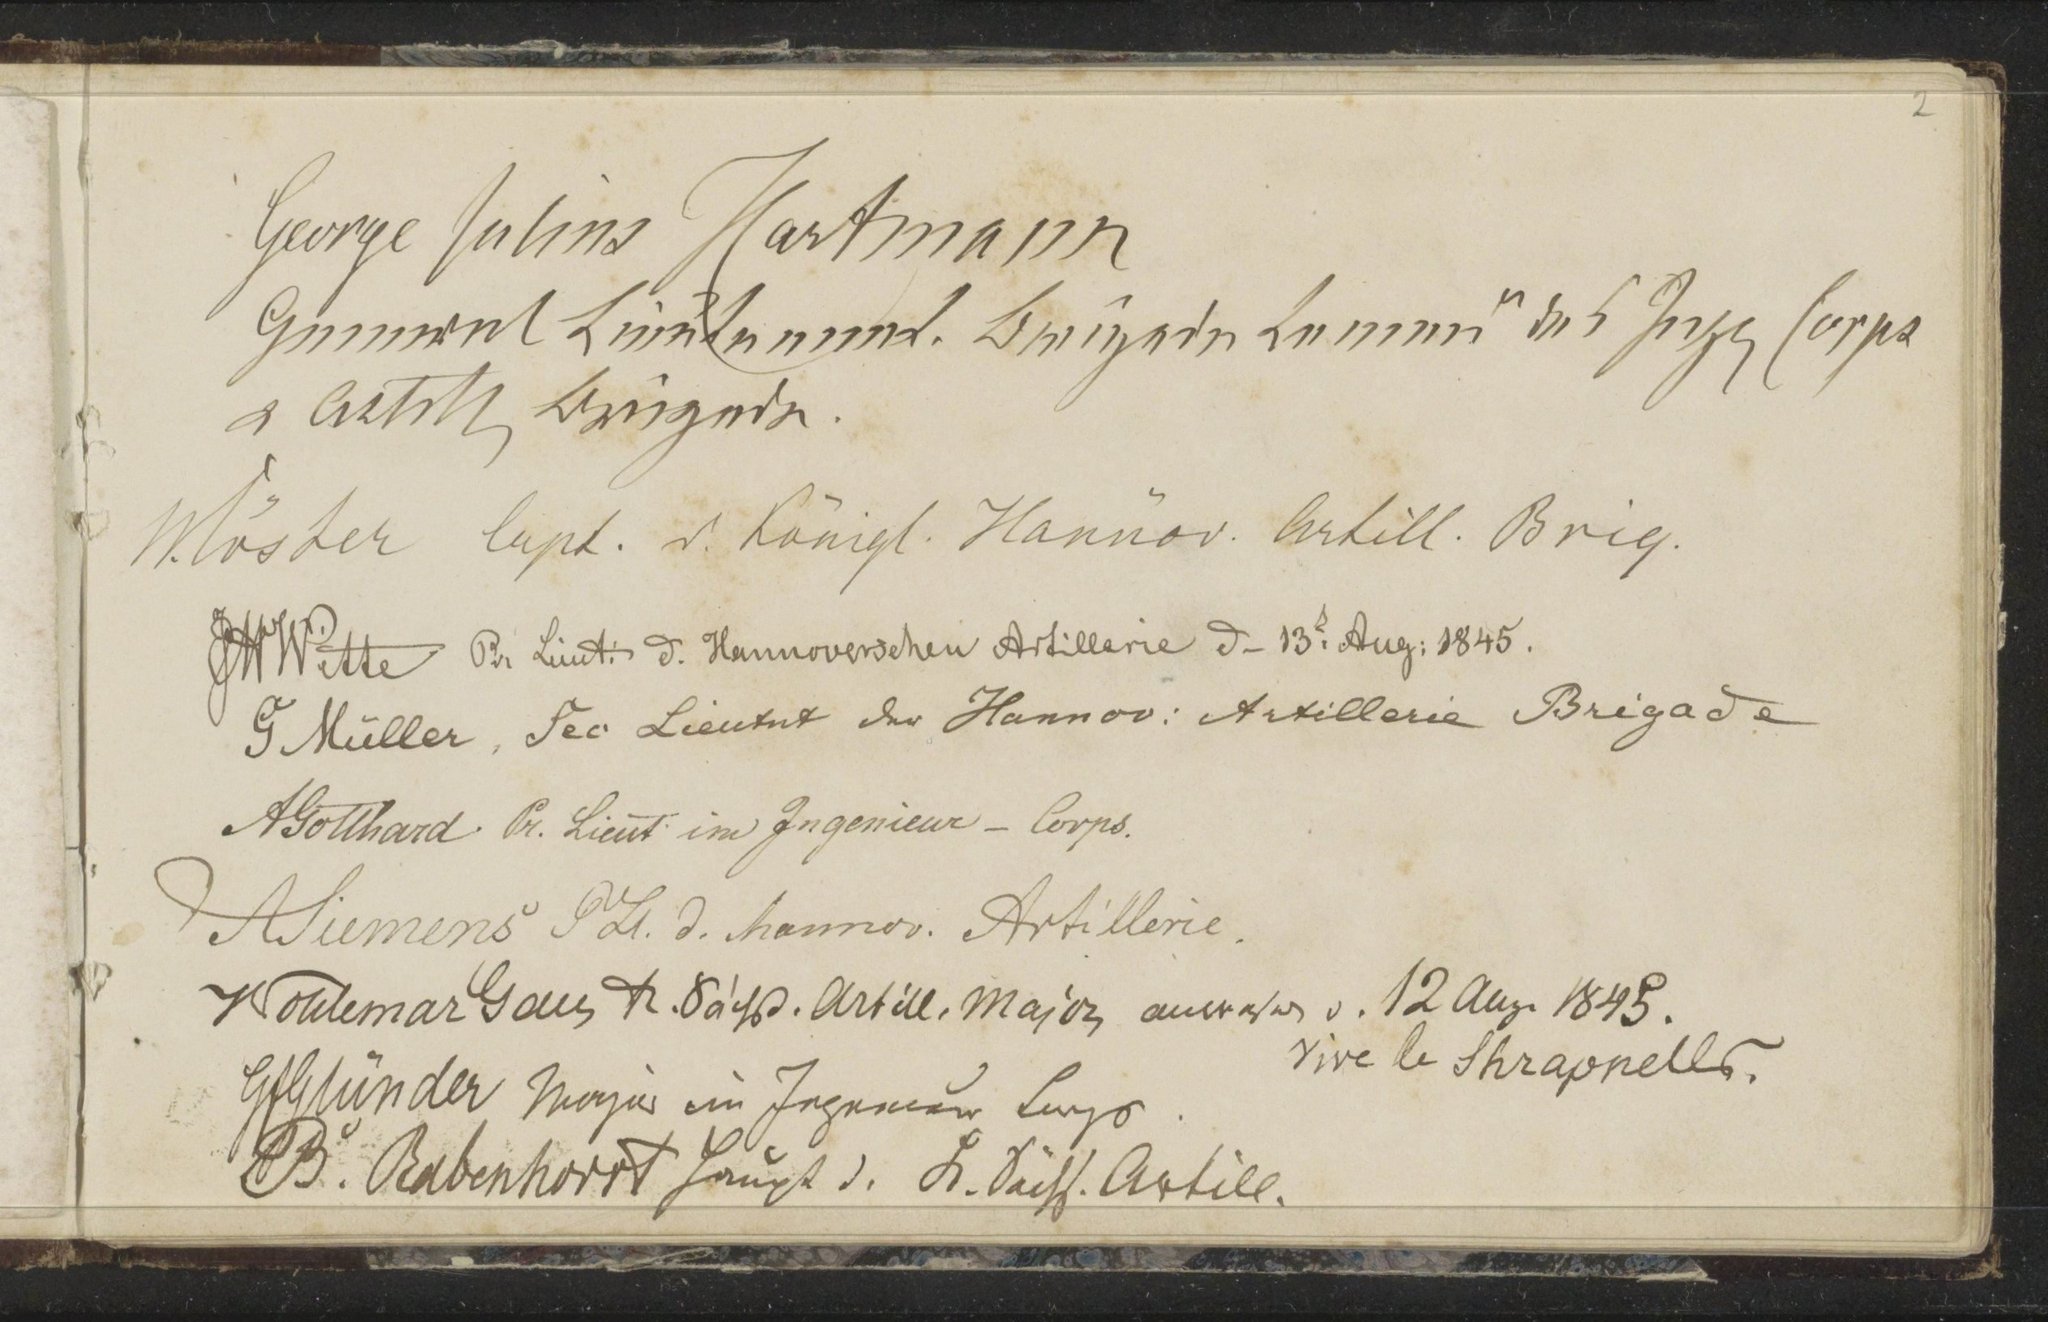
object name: sketchbook leaf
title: Namen van militairen uit Hannover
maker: christian heinrich gottlieb steuerwald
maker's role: draughtsman, print maker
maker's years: 1802-1874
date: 1808-1845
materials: ink, paper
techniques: pen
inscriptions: date and inscription: ‘George Julius Hartmann/ ...’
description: Blad 2 recto uit een schetsboek met 61 bladen.